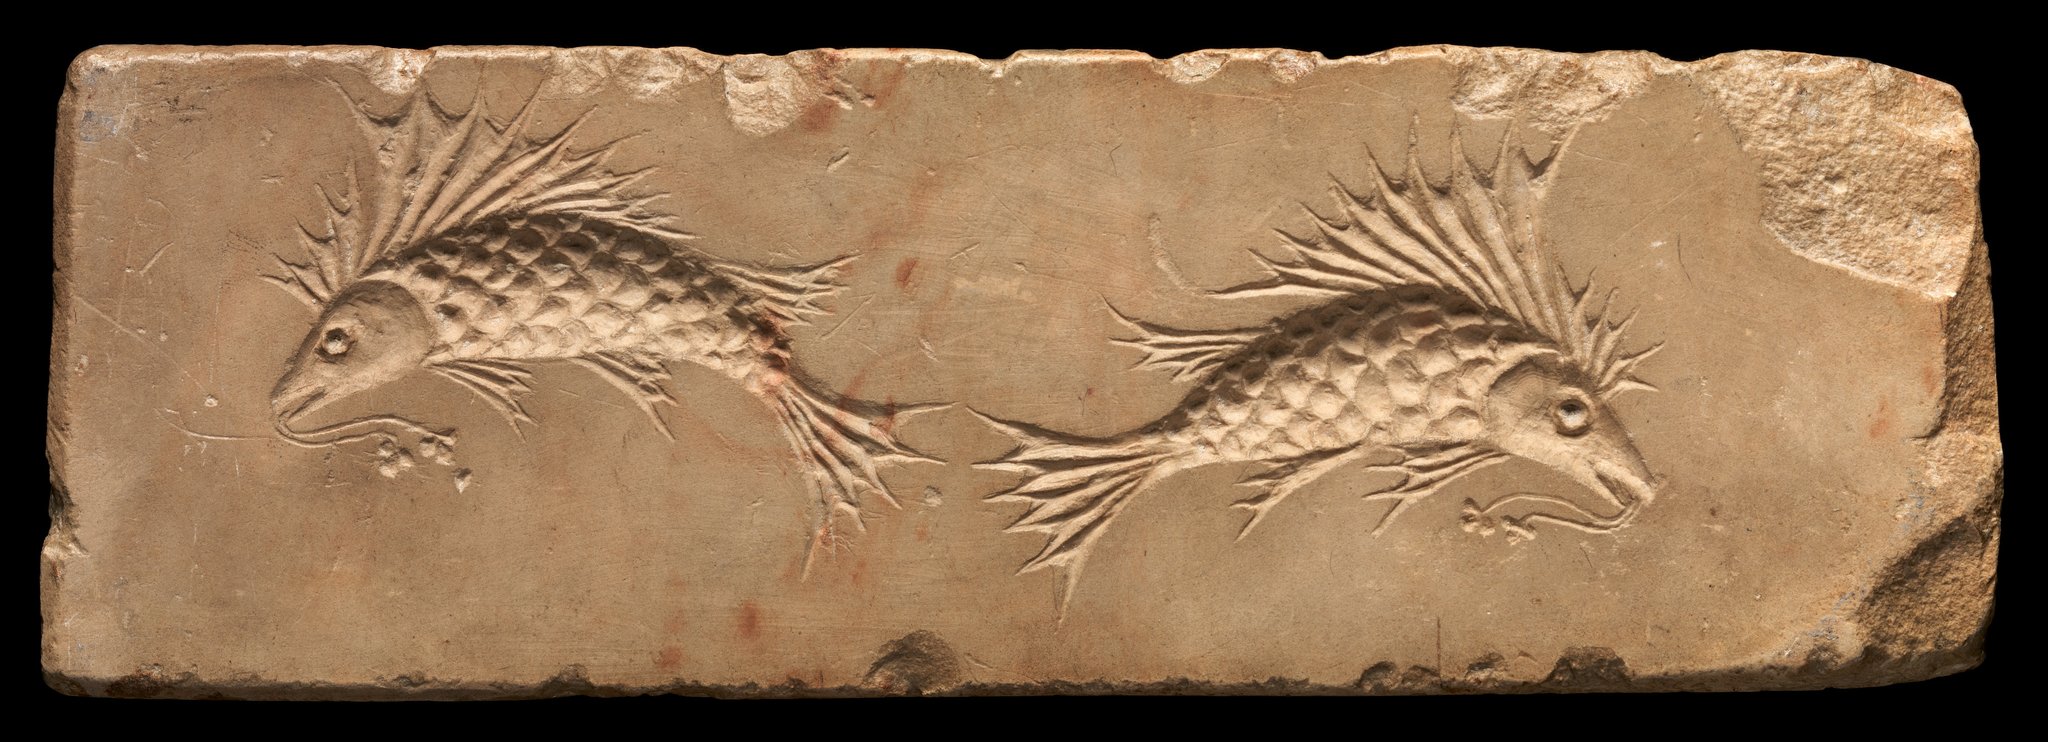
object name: relief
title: Matrices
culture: german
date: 1220-1272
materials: limestone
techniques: lithograph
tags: fish